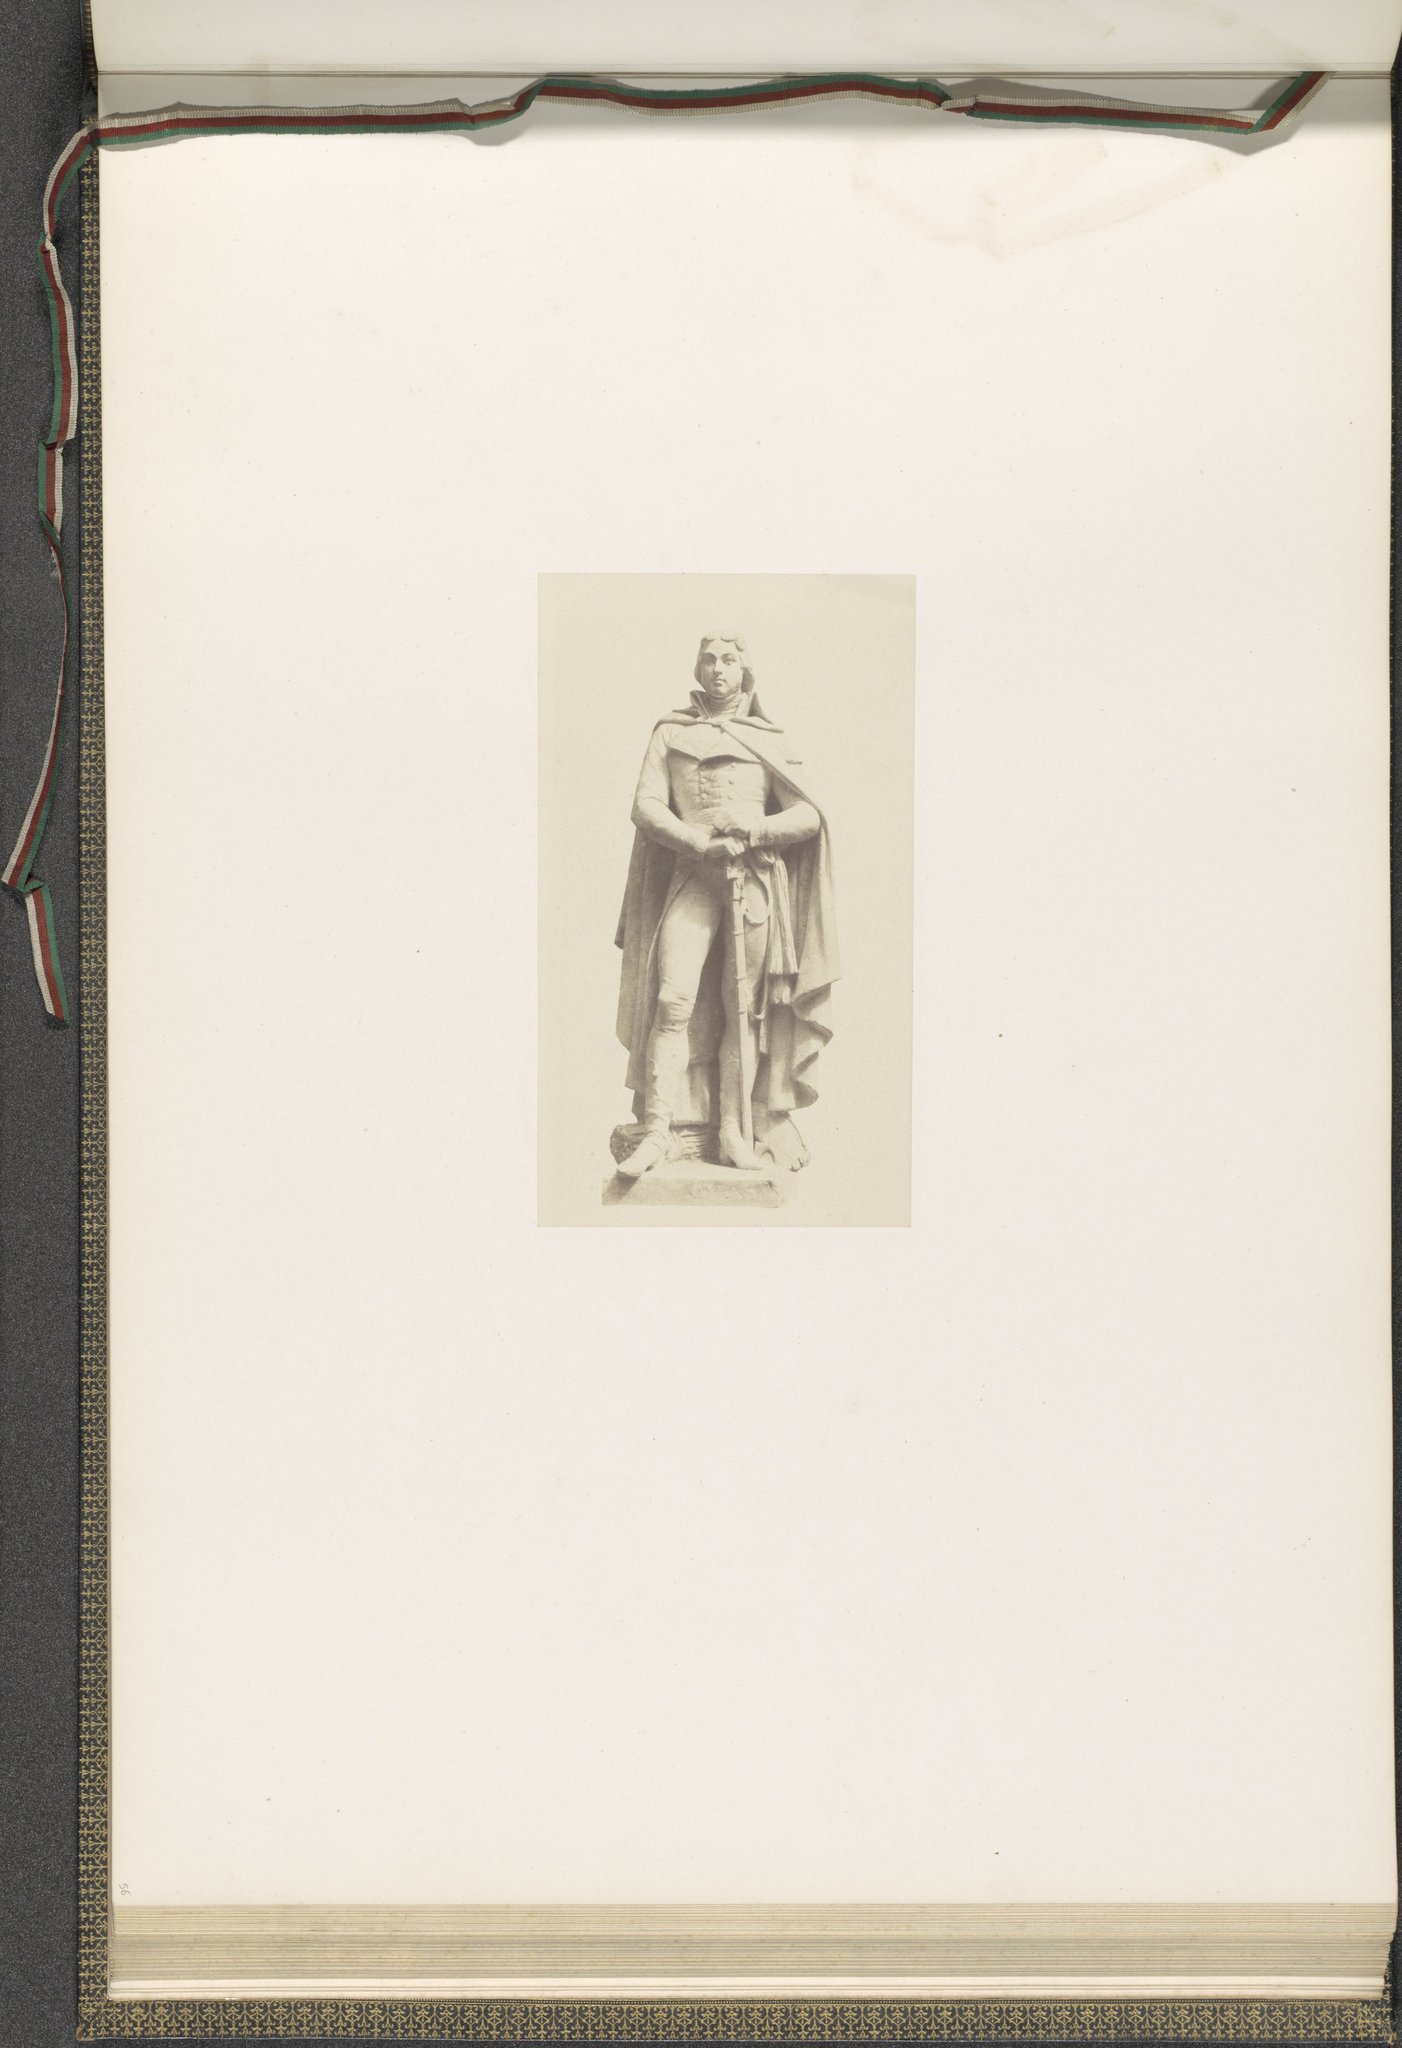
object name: album leaf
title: Gipsmodel voor beeldhouwwerk op het Palais du Louvre: "Hoche" door Eugène Farochon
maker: édouard denis baldus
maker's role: fotograaf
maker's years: 1813-1889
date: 1855-1857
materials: paper, photographic support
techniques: salted paper print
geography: paris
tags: piece of sculpture, reproduction of a piece of sculpture, permanent exhibition, museum, paris, tuileries palace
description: Onderdeel van Réunion des Tuileries au Louvre 1852-1857, album 4.